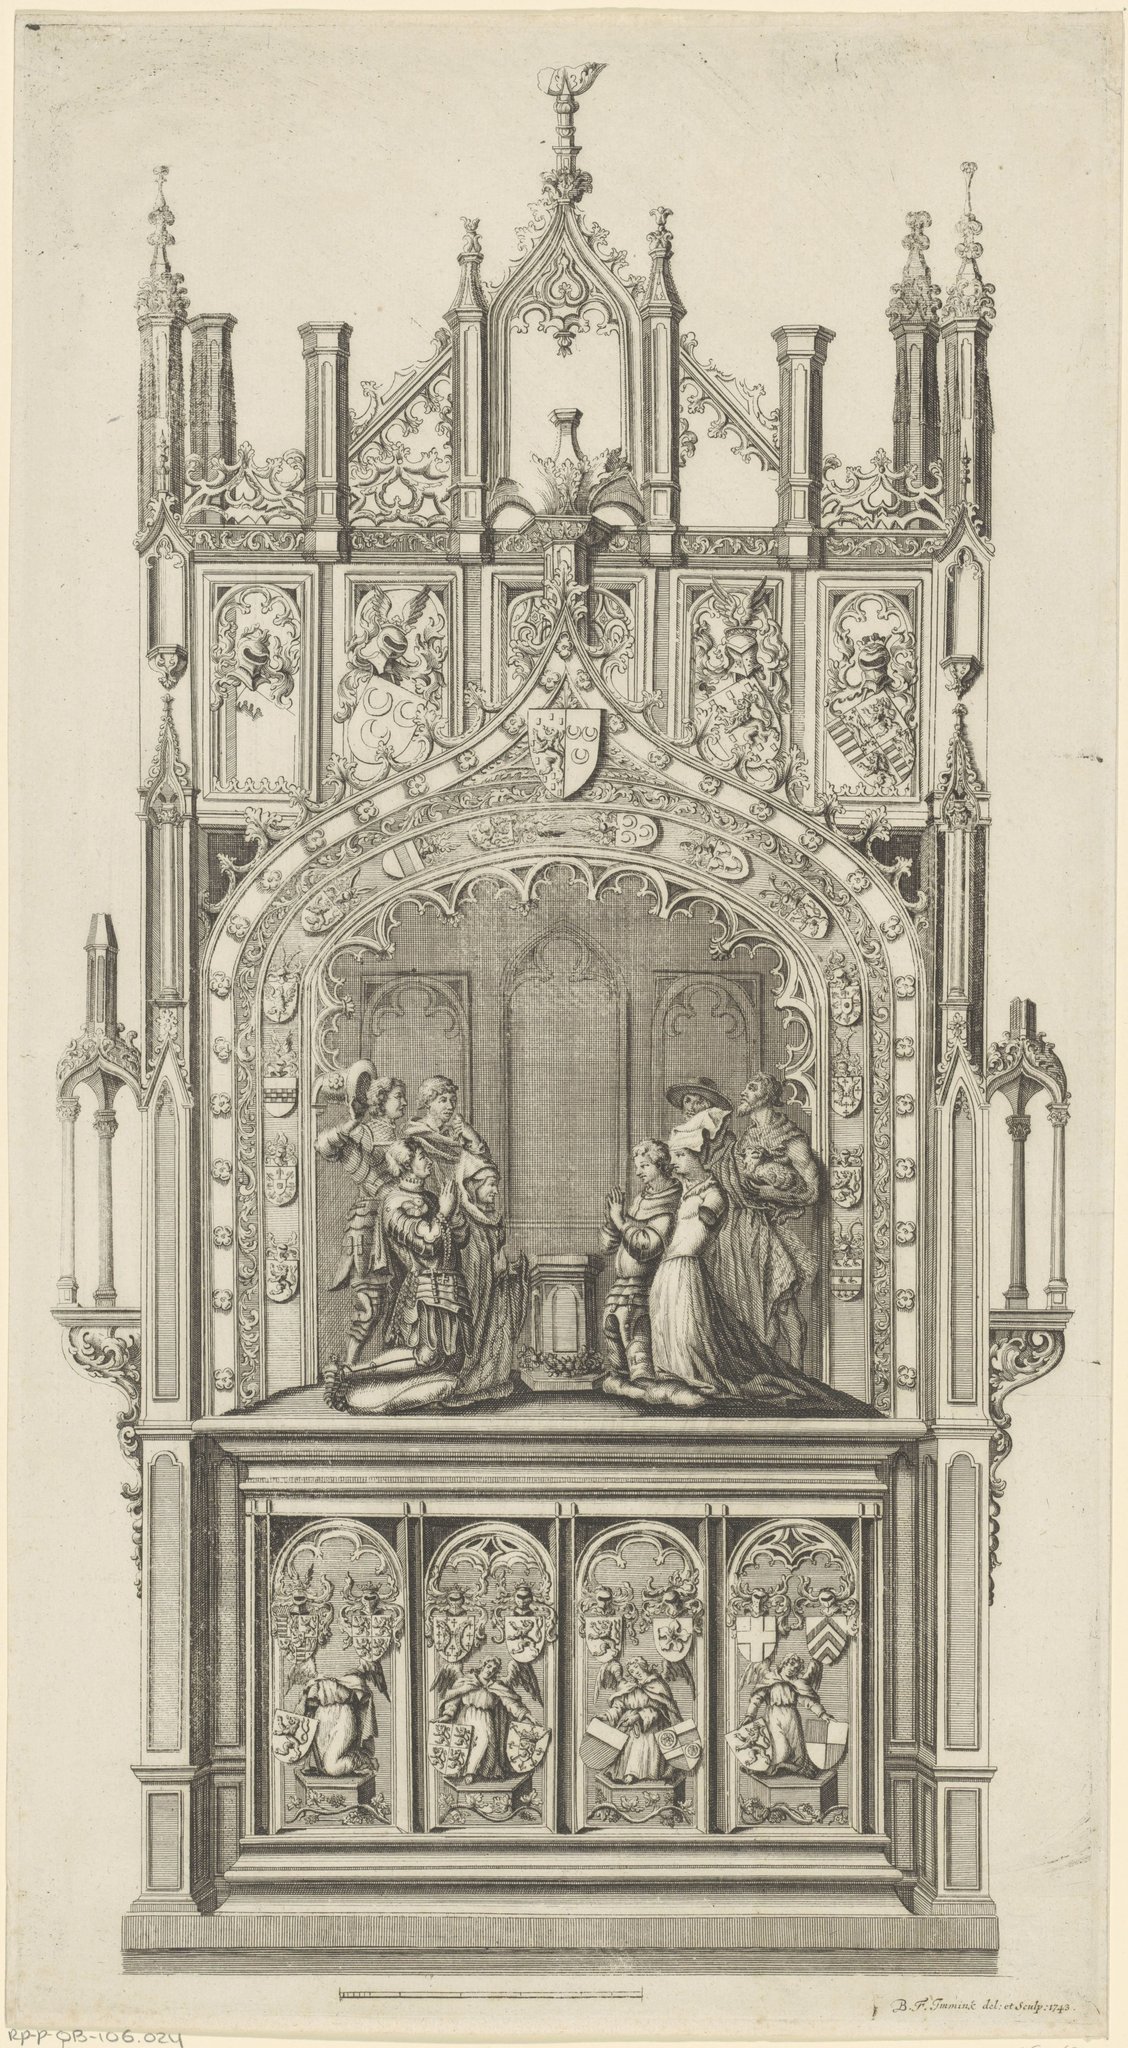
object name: print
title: Grafmonument voor Engelbrecht I, graaf van Nassau-Dillenburg, Johanna van Polanen, Johan IV, graaf van Nassau-Dillenburg, en Maria van Loon-Heinsberg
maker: b.f. immink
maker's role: print maker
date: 1743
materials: paper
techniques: engraving, etching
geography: the hague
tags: earl, grave-building, monumental tomb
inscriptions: collector's mark: Lugt 963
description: De hier vermelde titel verwijst naar de hoogst verkregen titel van de geportretteerde, niet per se naar de titel die de geportretteerde op deze voorstelling draagt.